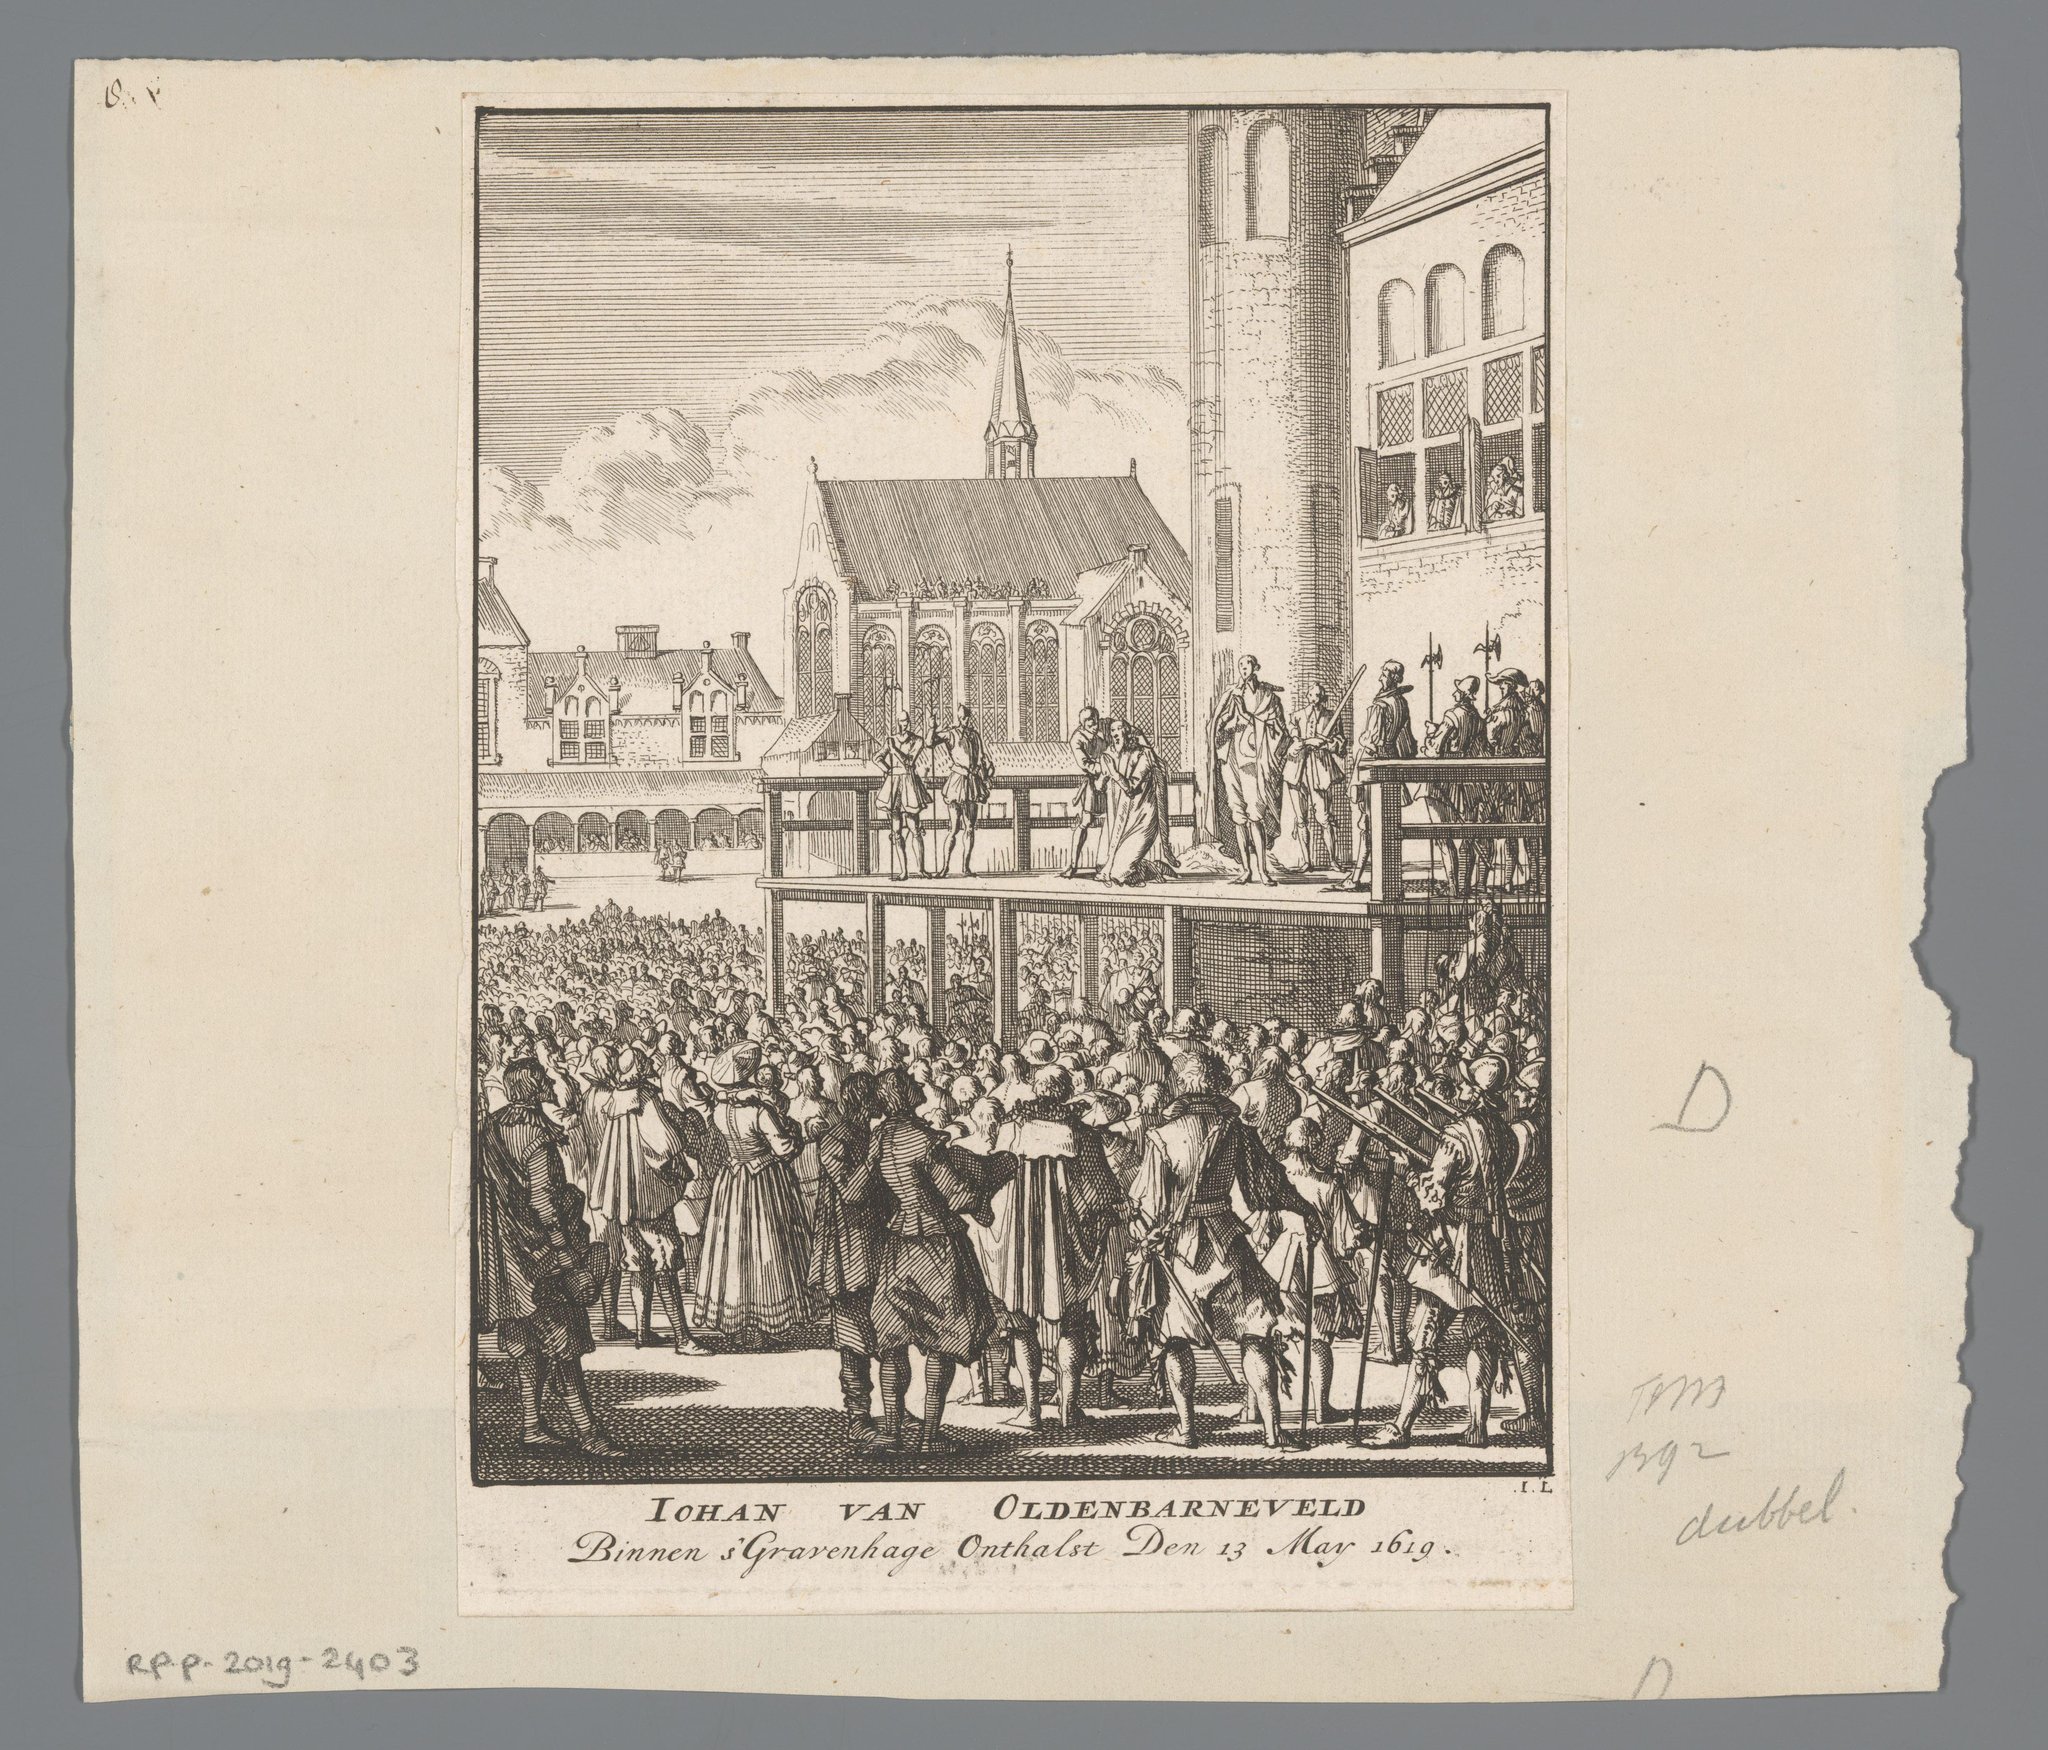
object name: print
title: Johan van Oldenbarnevelt knielt op het schavot voor zijn onthoofding, 1619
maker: jan luyken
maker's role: draughtsman, print maker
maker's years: 1649-1712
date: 1698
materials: paper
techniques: etching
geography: amsterdam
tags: johan van oldenbarnevelt, maurice (prince of orange), on the scaffold or place of execution, violent death by beheading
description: Andere staat van prent ook gebruikt in: Bosch, Lambert van den. Treur-toonneel der doorluchtige mannen, of op- en ondergang der grooten, vertoont in de rampzalige geschiedenissen van (…). 3 dln. Amsterdam: Jan Claesz ten Hoorn, 1698, dl. 2, afd. 4, p. 61.